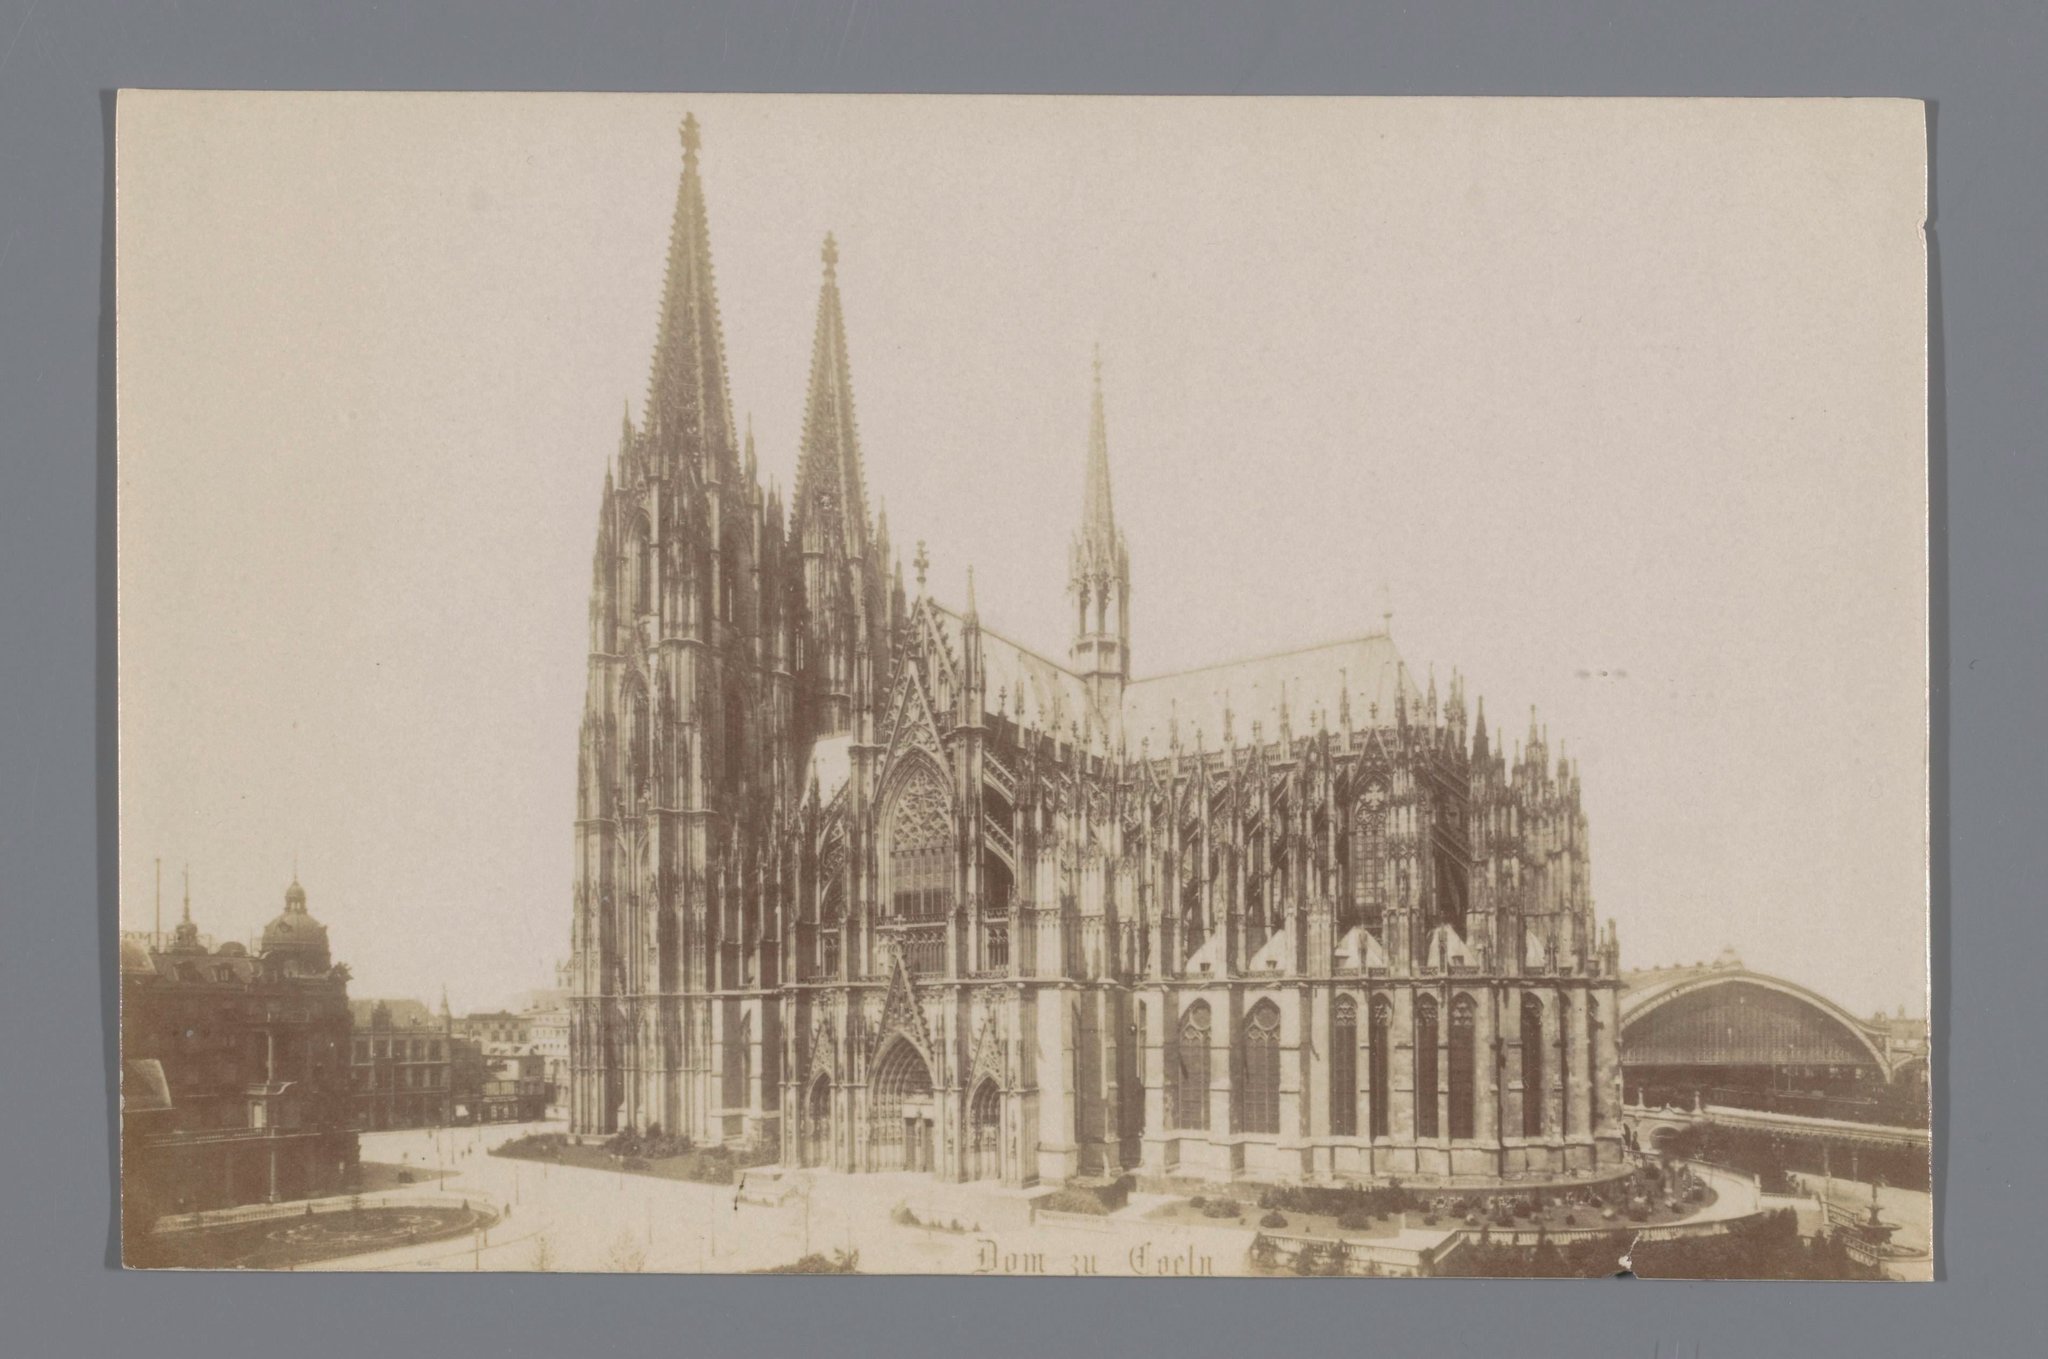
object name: photograph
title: Dom zu Coeln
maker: Anonymous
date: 1894-1910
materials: paper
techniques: albumen print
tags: church (exterior)